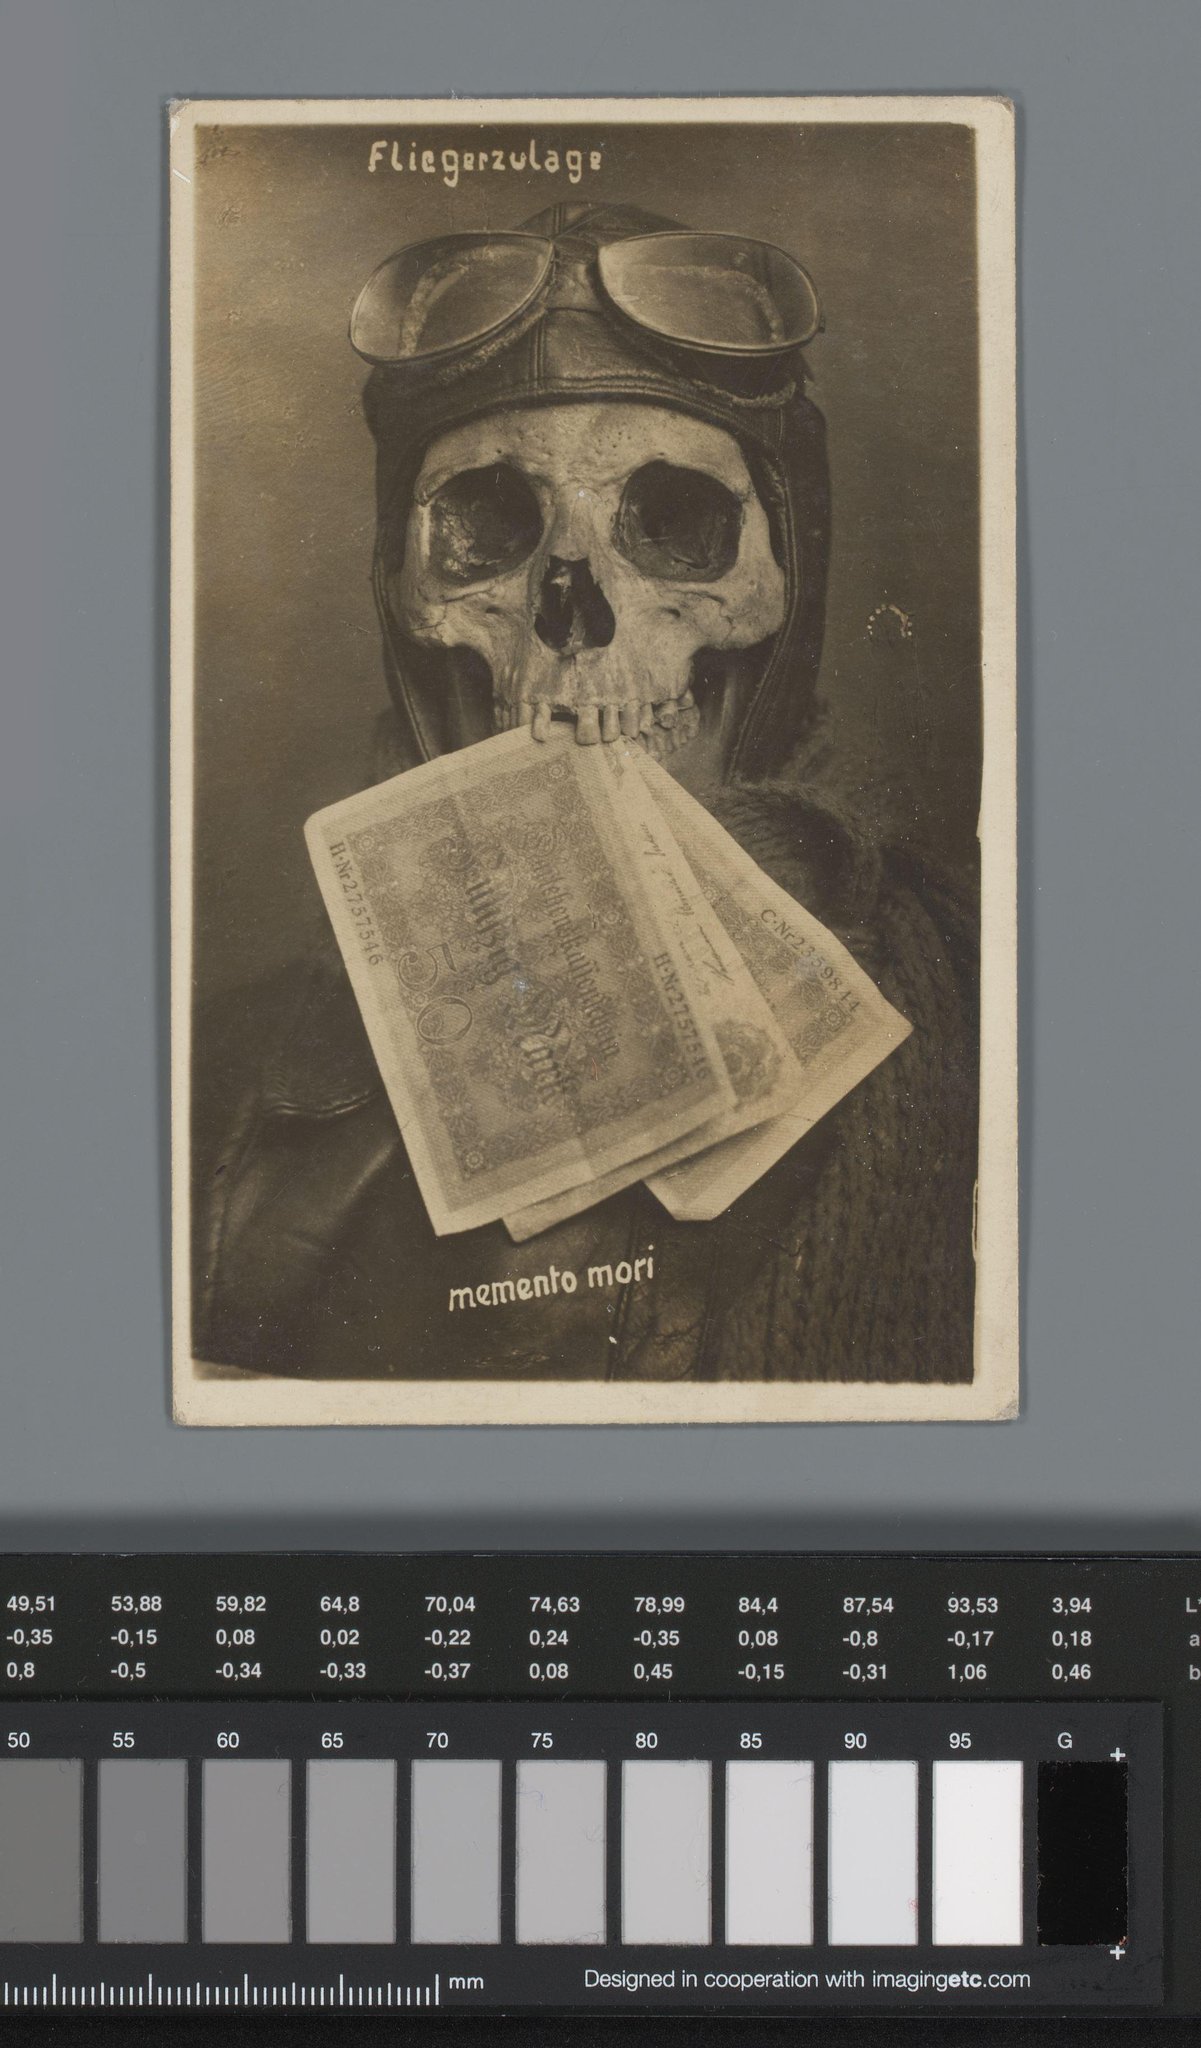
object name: photograph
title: Doodshoofd met Duitse vliegenier, met bankbiljetten tussen de kaken geklemd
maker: Anonymous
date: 1914-1918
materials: photographic support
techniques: gelatin silver print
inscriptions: inscription: ‘Fliegerzulage / memento mori’, number: ‘5013’